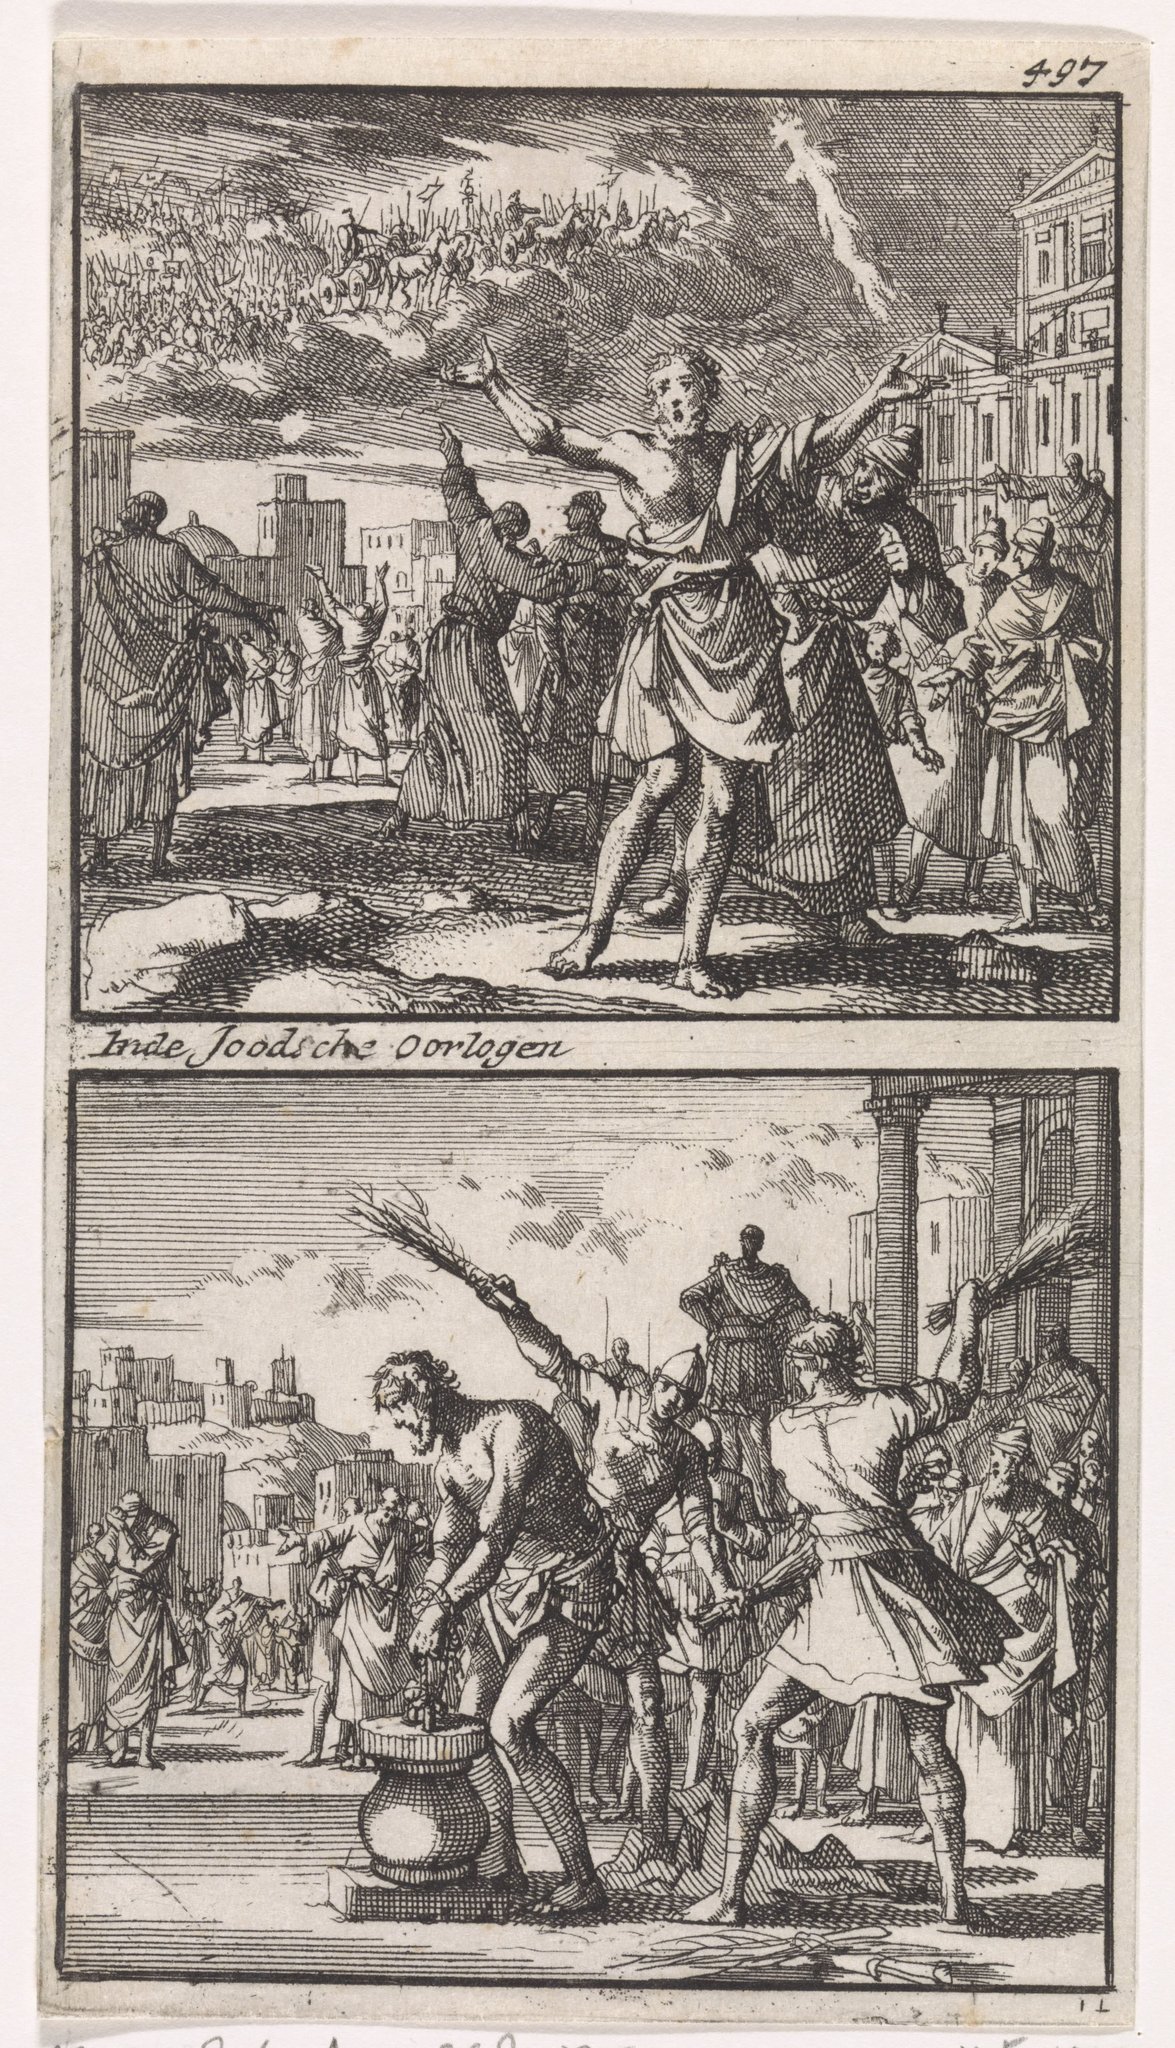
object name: book illustration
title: Jezus ben Ananias weeklaagt over het lot van Jeruzalem / Jezus ben Ananias door de Romeinen gegeseld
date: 1698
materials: paper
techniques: etching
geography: amsterdam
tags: flogging, scourging (in public)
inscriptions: collector's mark: Lugt 2228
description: Illustratie uit: Josephus, Flavius. XX. boeken van de oude geschiedenissen der joden, 4 delen. Amsterdam: Barent Visscher, Willem de Coup, Willem van Lamsveld, Andries van Damme, 1698, dl. III.